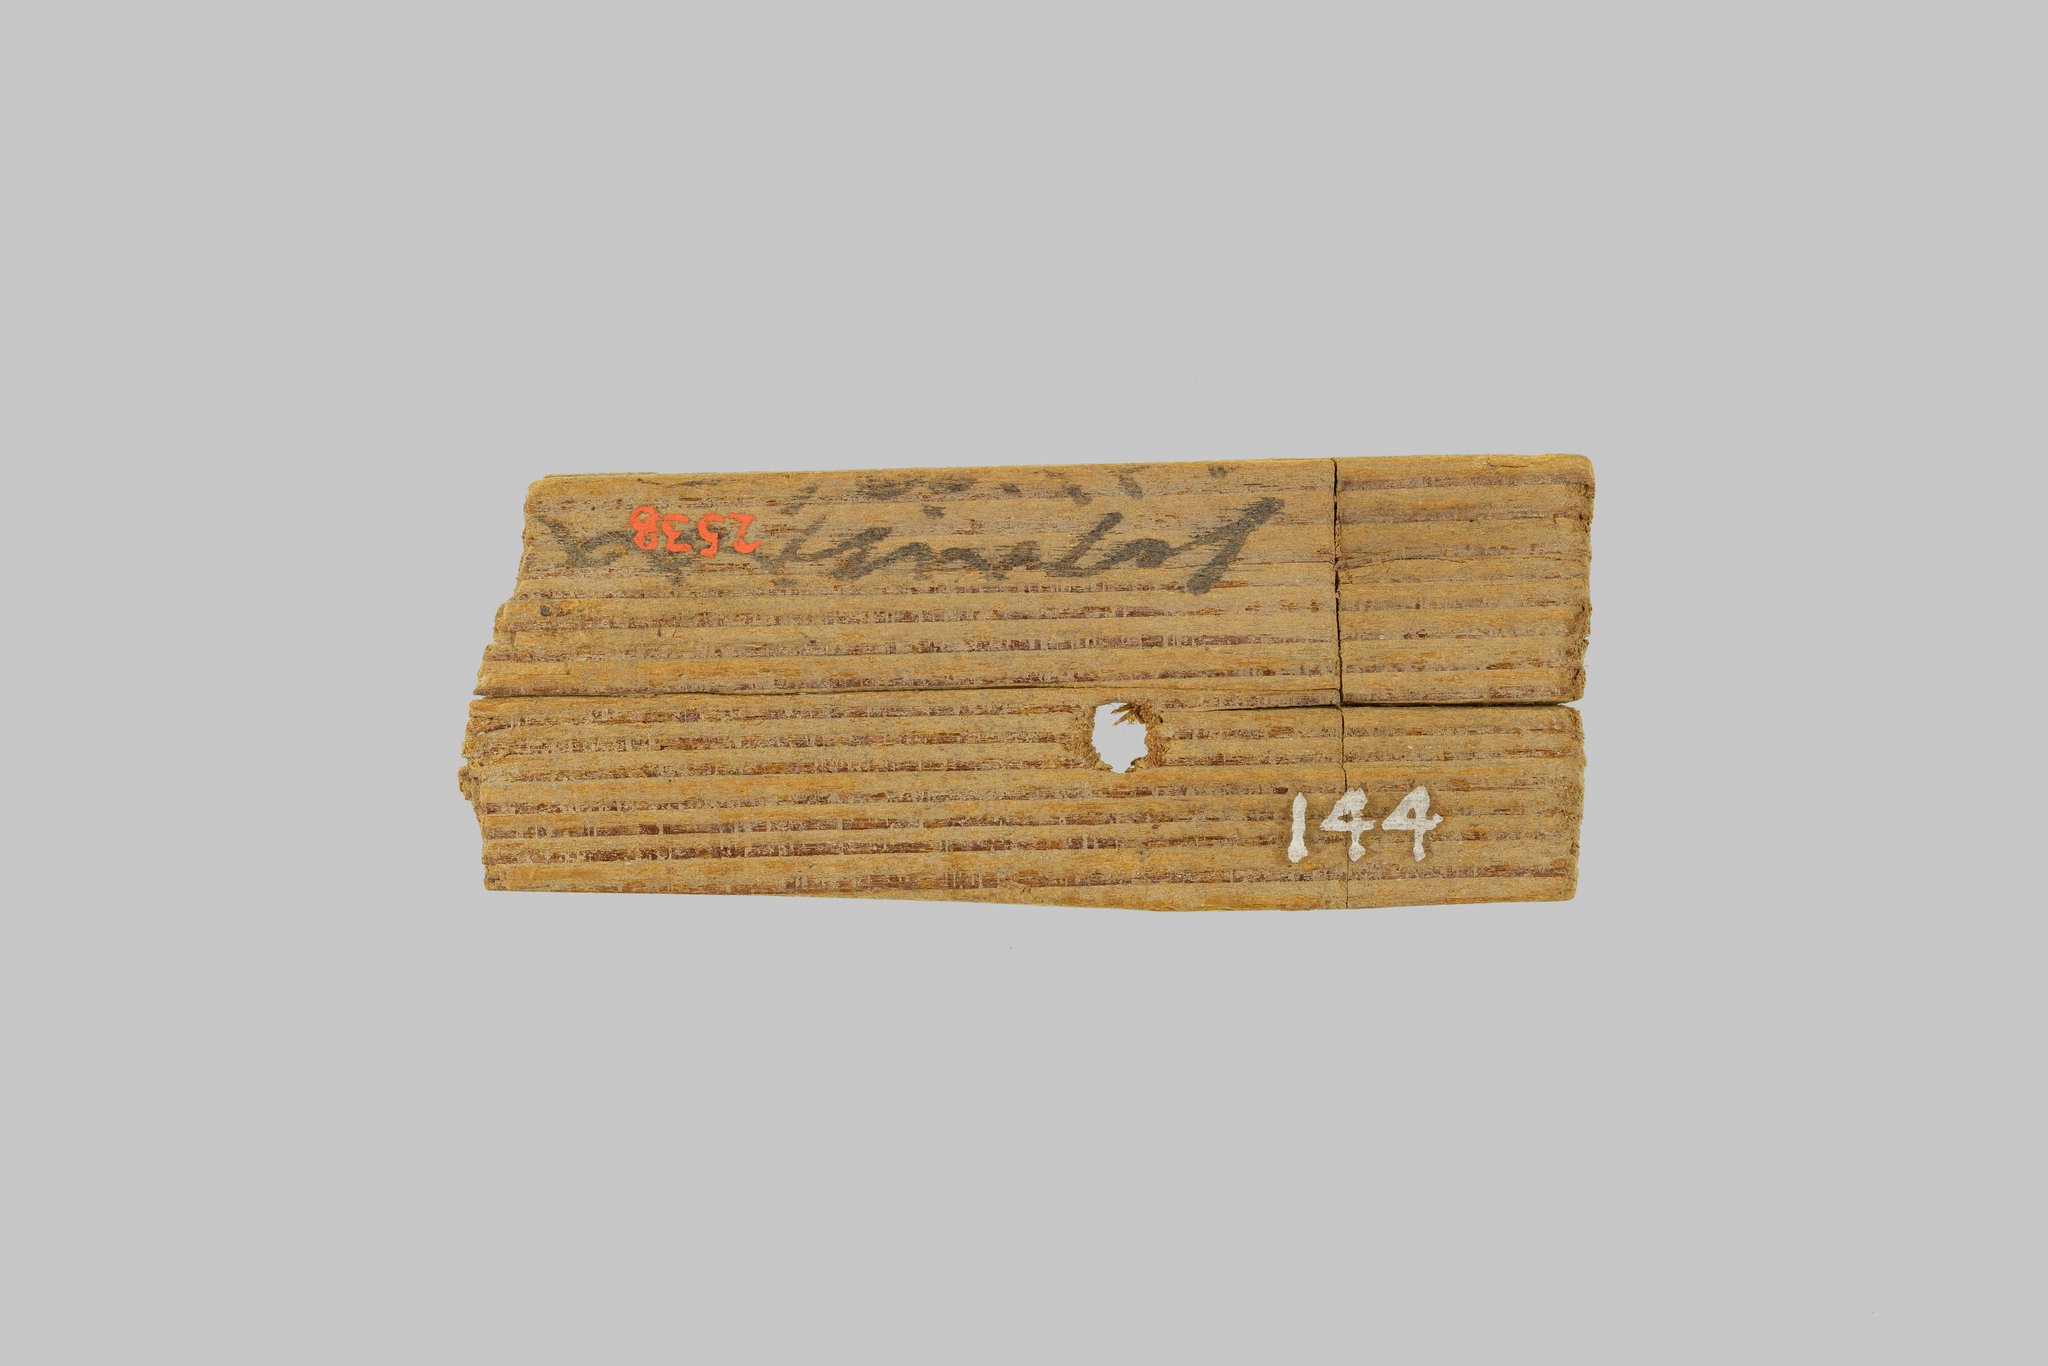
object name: mummy label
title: Fragment of a mummy label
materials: ink, wood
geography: egypt